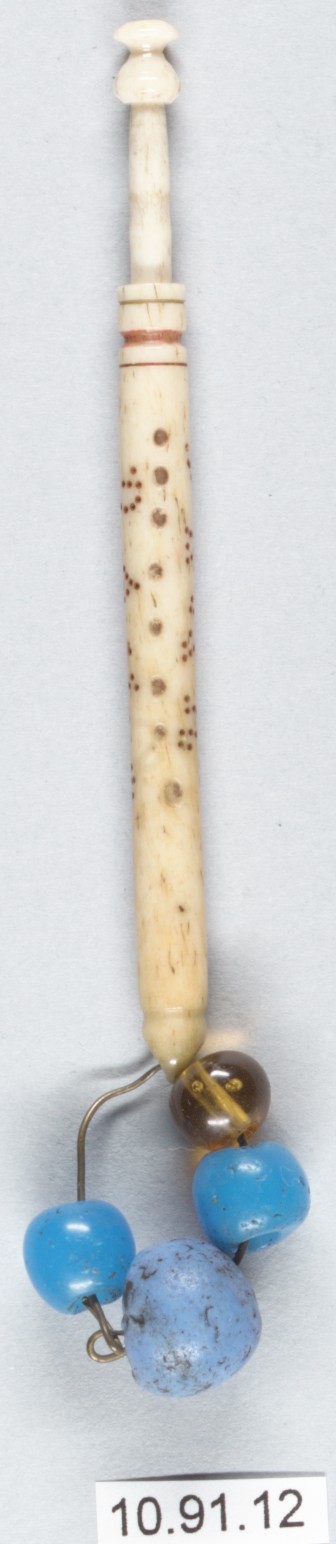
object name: bobbin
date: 1801-1900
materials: bone